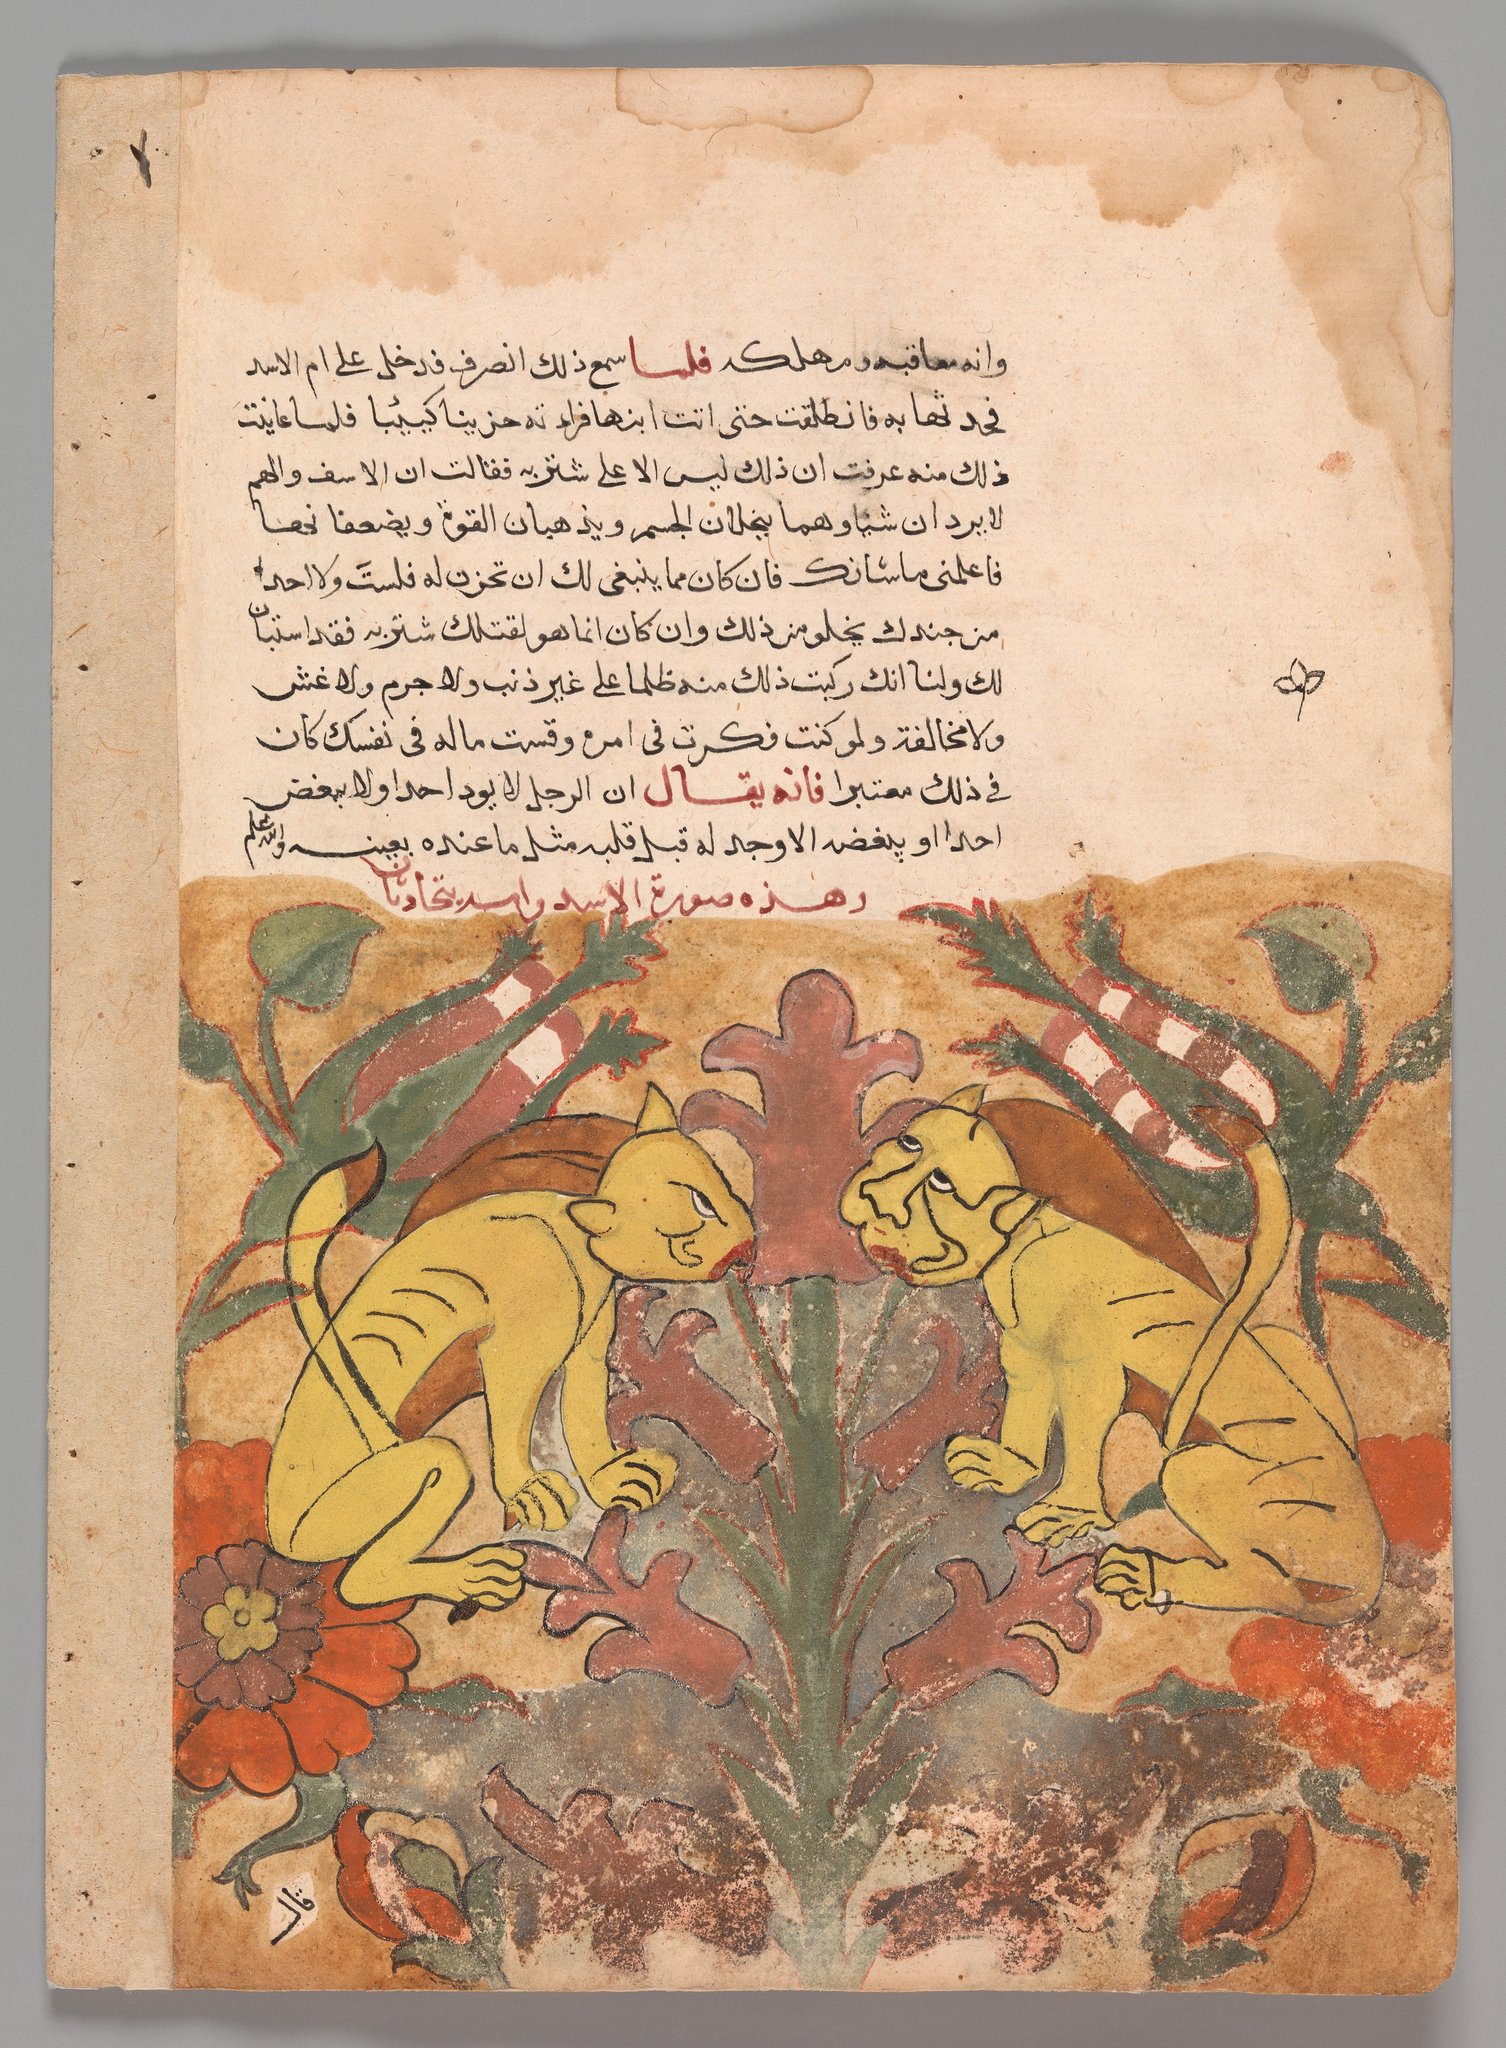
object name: folio from an illustrated manuscript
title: Folio from a Kalila wa Dimna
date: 1526-1550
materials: ink, paper, watercolor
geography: india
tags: tigers